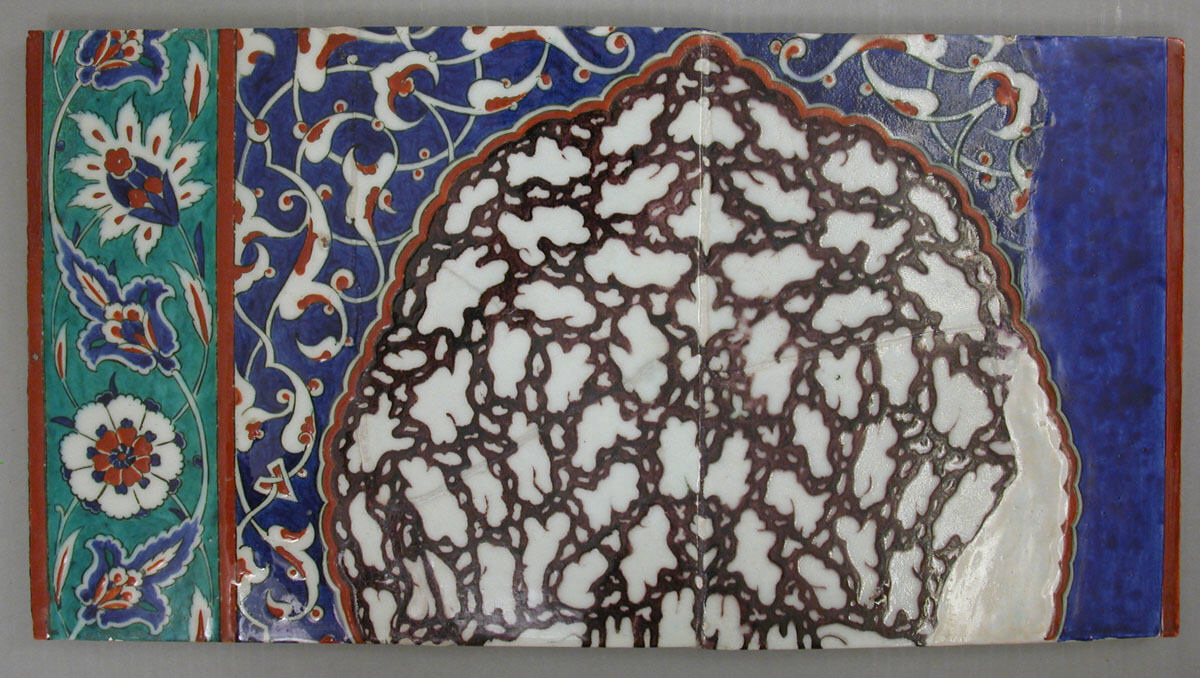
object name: tile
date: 1567-1600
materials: stonepaste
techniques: glazing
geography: turkey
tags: flowers,leaves